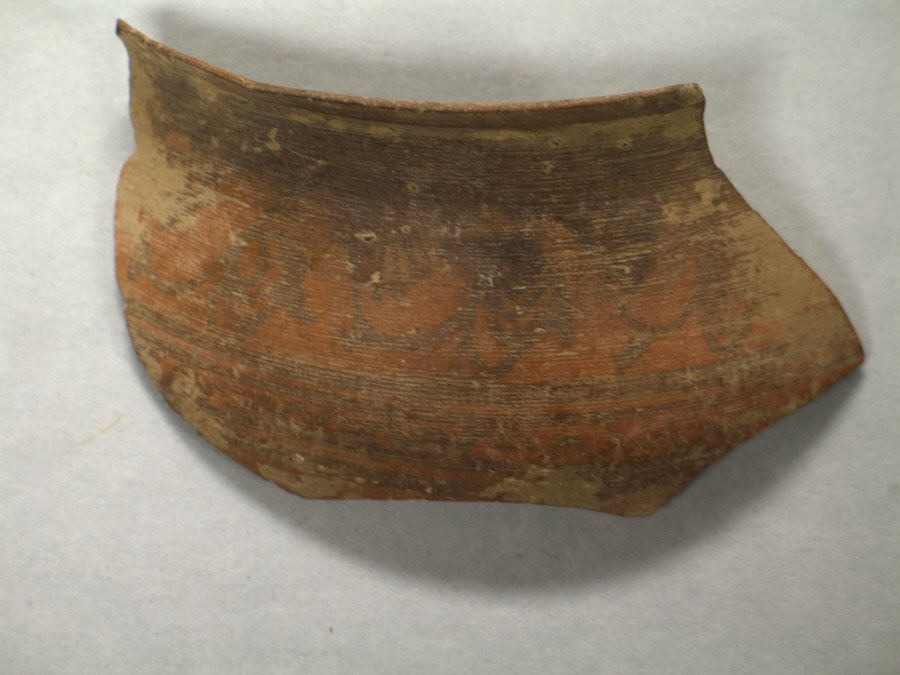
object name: shard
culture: pakistani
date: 301-500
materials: terracotta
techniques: painting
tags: gandhara